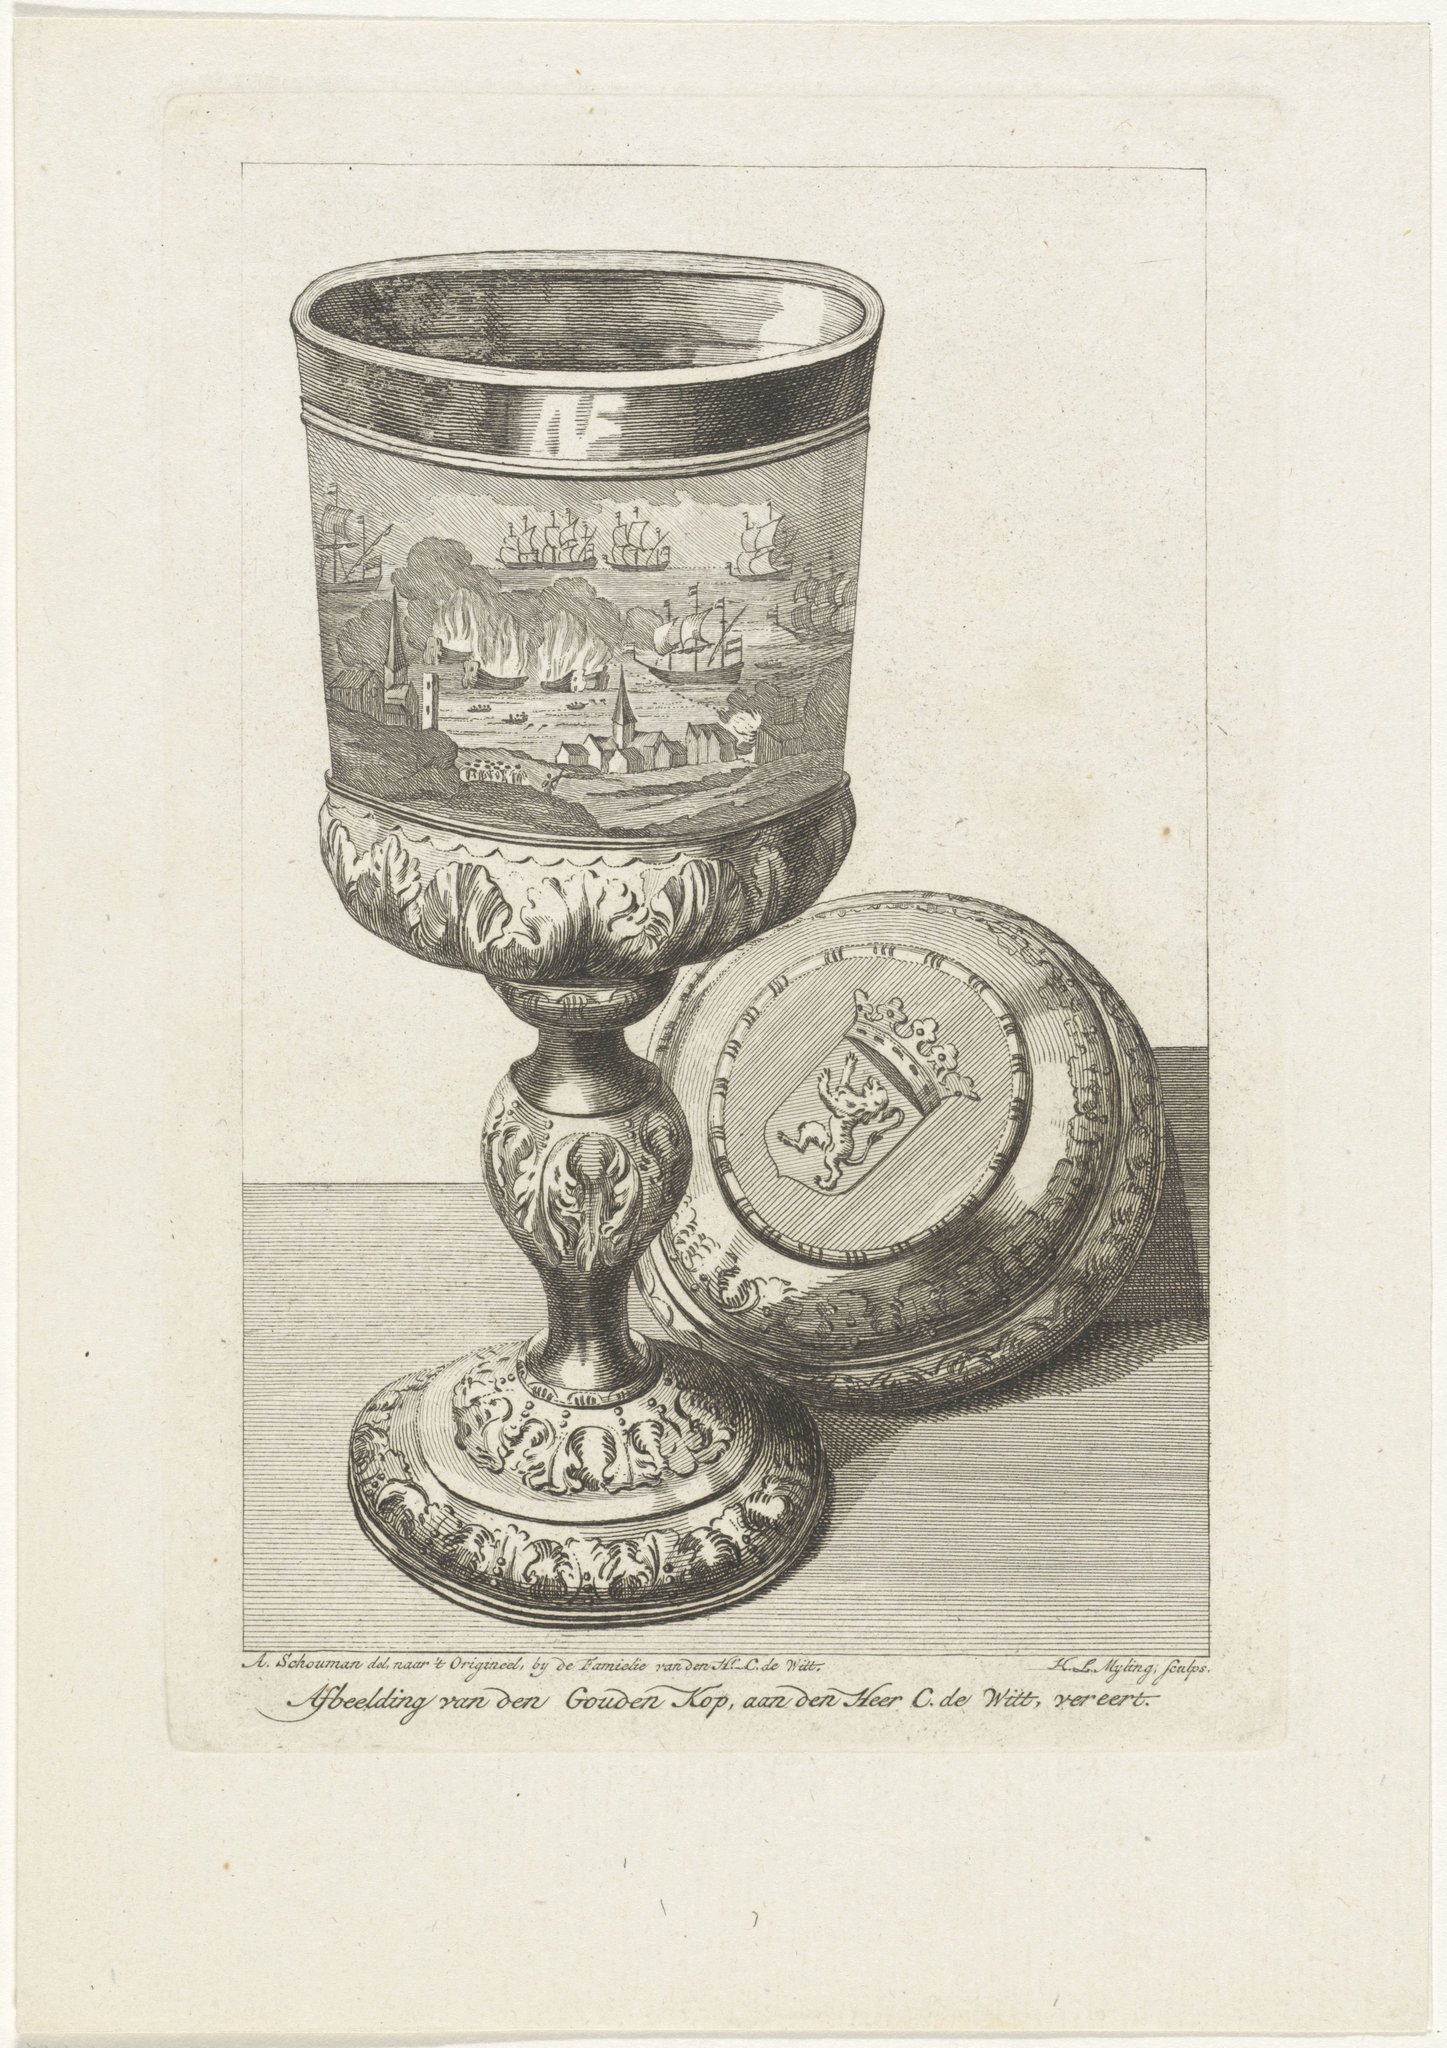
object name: print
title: Gouden beker van Cornelis de Witt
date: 1777-1821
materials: paper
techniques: etching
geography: netherlands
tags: dordrecht, the hague, cornelis de witt, sailing-ship, sailing-boat, cup, raid on the medway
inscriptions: collector's mark: Lugt 2760, collector's mark: Lugt 2228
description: De gouden beker, die Cornelis de Witt ontving van de Staten van Holland en de Staten van West-Friesland voor zijn aandeel in de Tocht naar Chatham in 1667. Op de beker een afbeelding van de Tocht naar Chatham waarbij de Engelse vloot werd vernietigd. Op het deksel het Nederlandse wapen met de Hollandse leeuw.